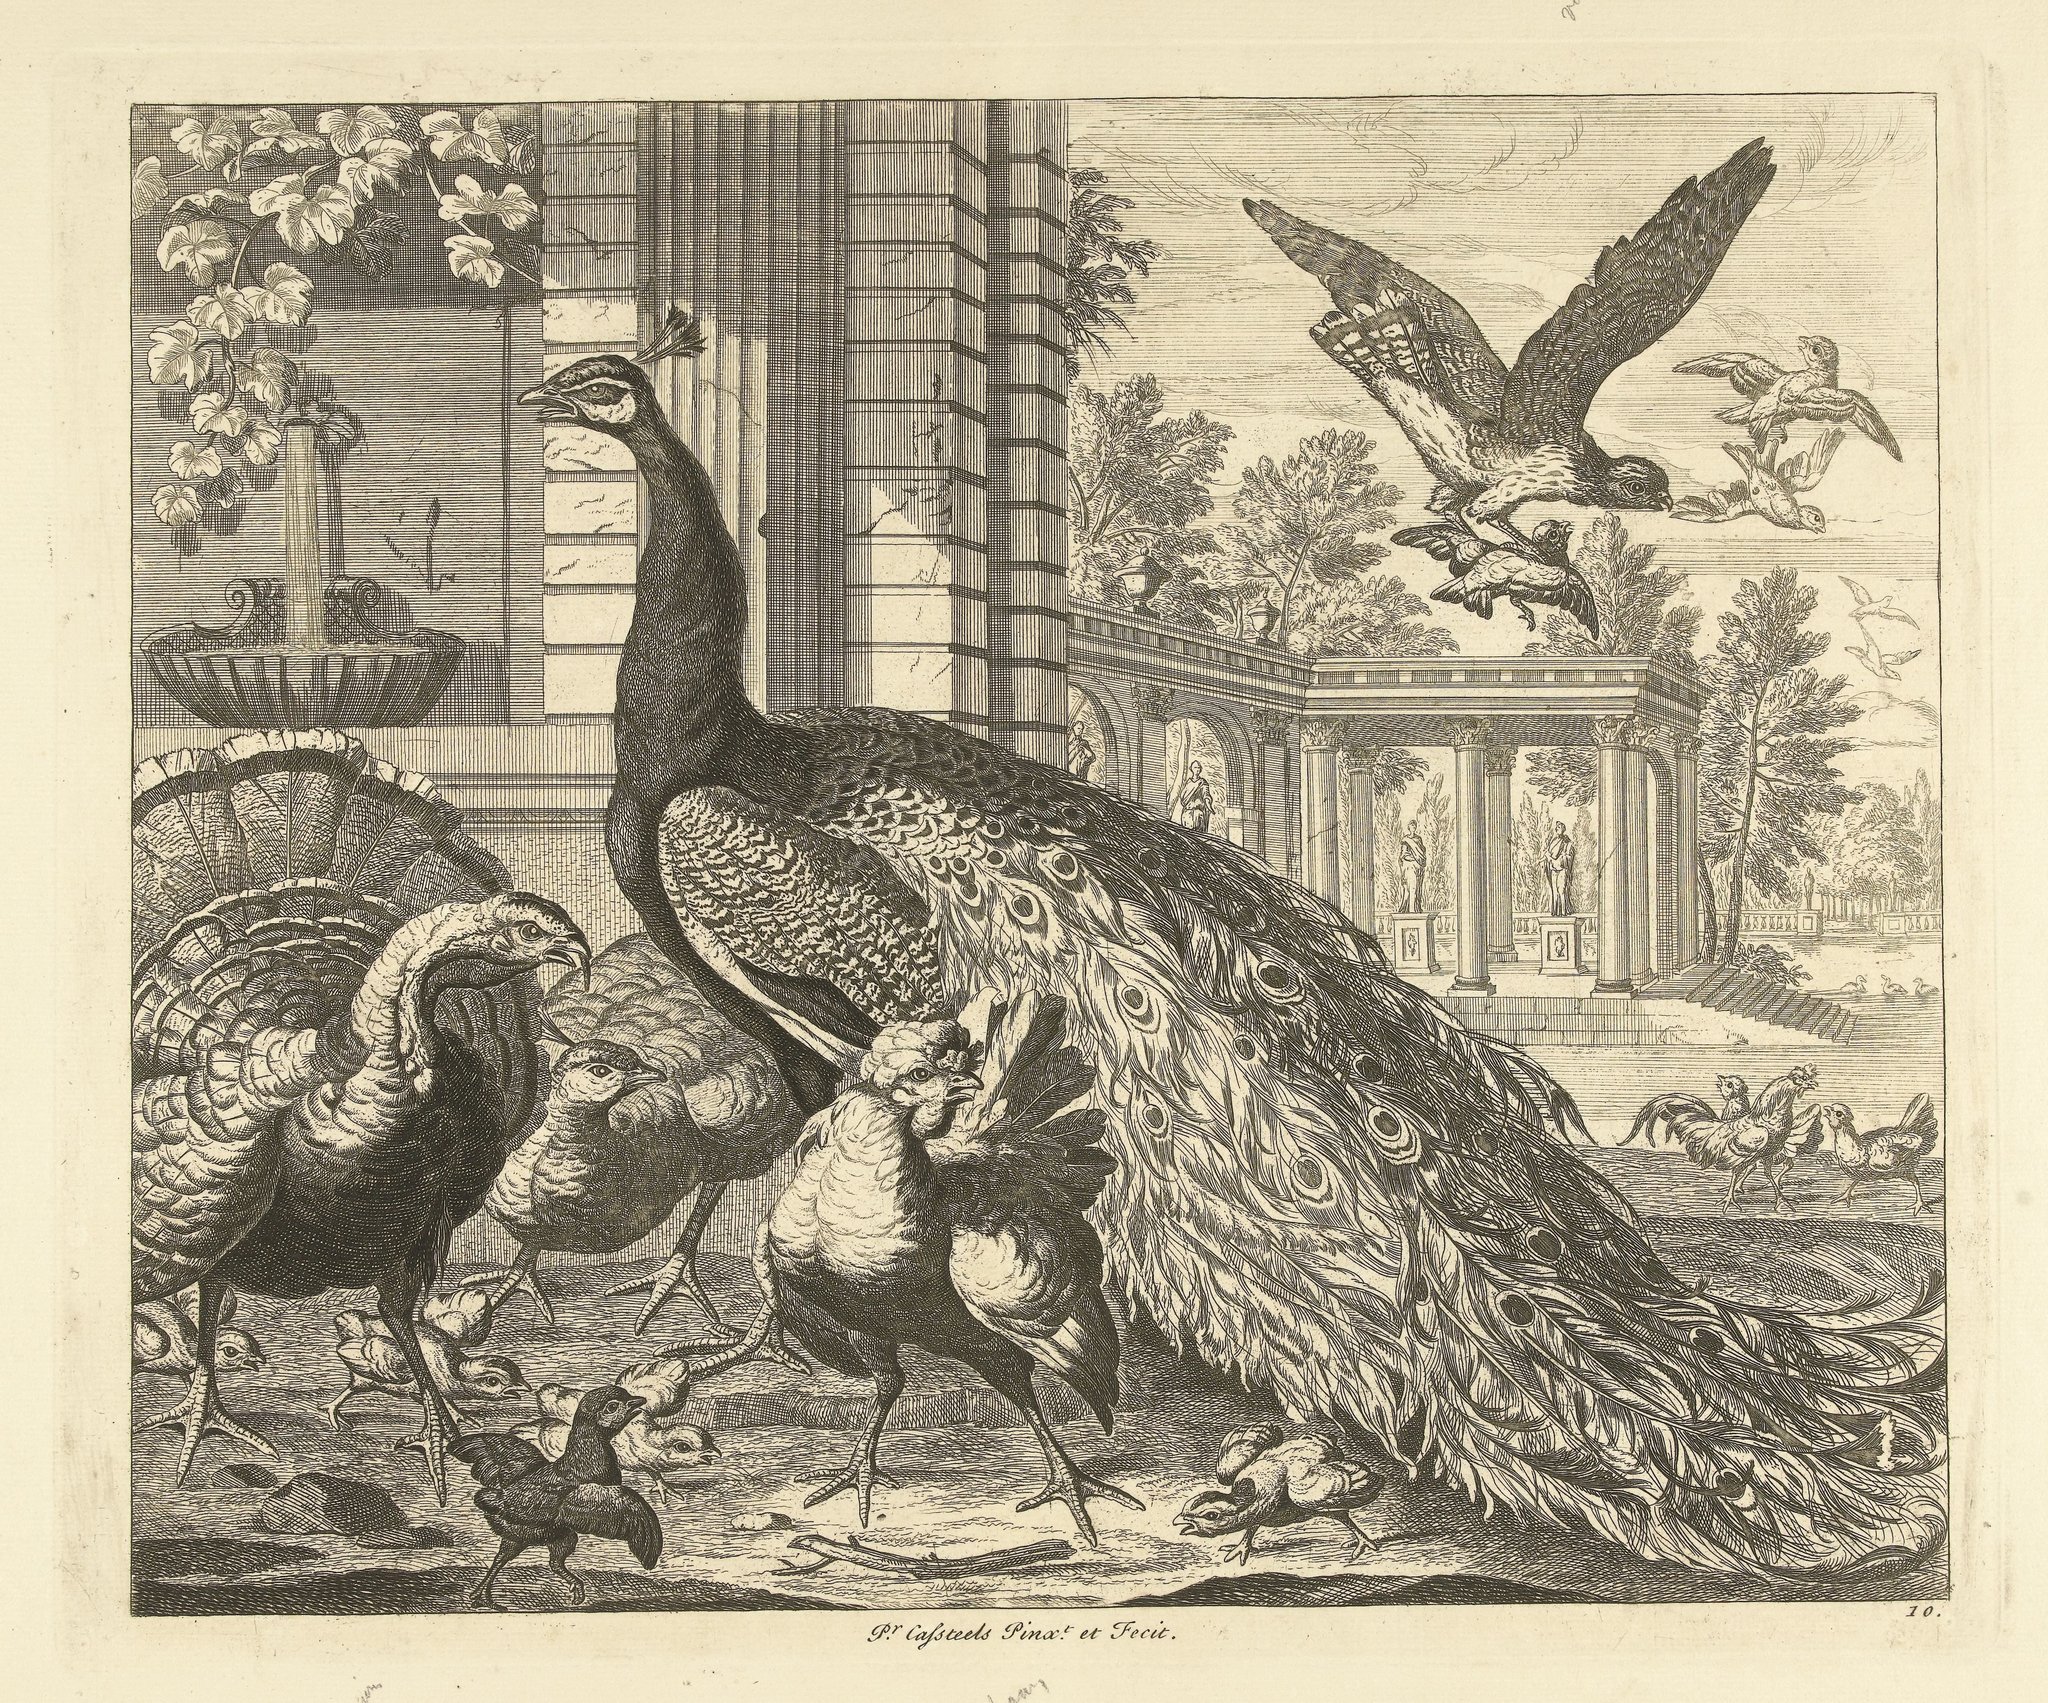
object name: print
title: Pauw en kalkoen bij een tuincolonnade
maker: peter casteels (iii)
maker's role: draughtsman, print maker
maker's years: 1684-1749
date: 1708-1749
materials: paper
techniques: etching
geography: london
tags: ornamental birds: peacock, pergola, walker and runner birds: turkey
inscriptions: collector's mark: Lugt 2228